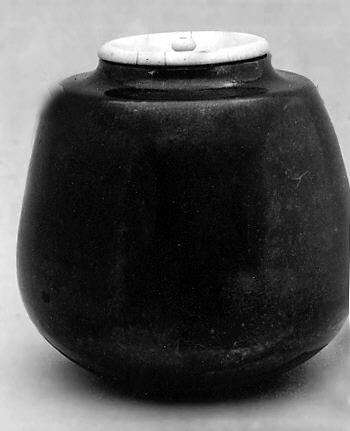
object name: tea jar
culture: japanese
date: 1701-1800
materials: glaze, paste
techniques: overglaze